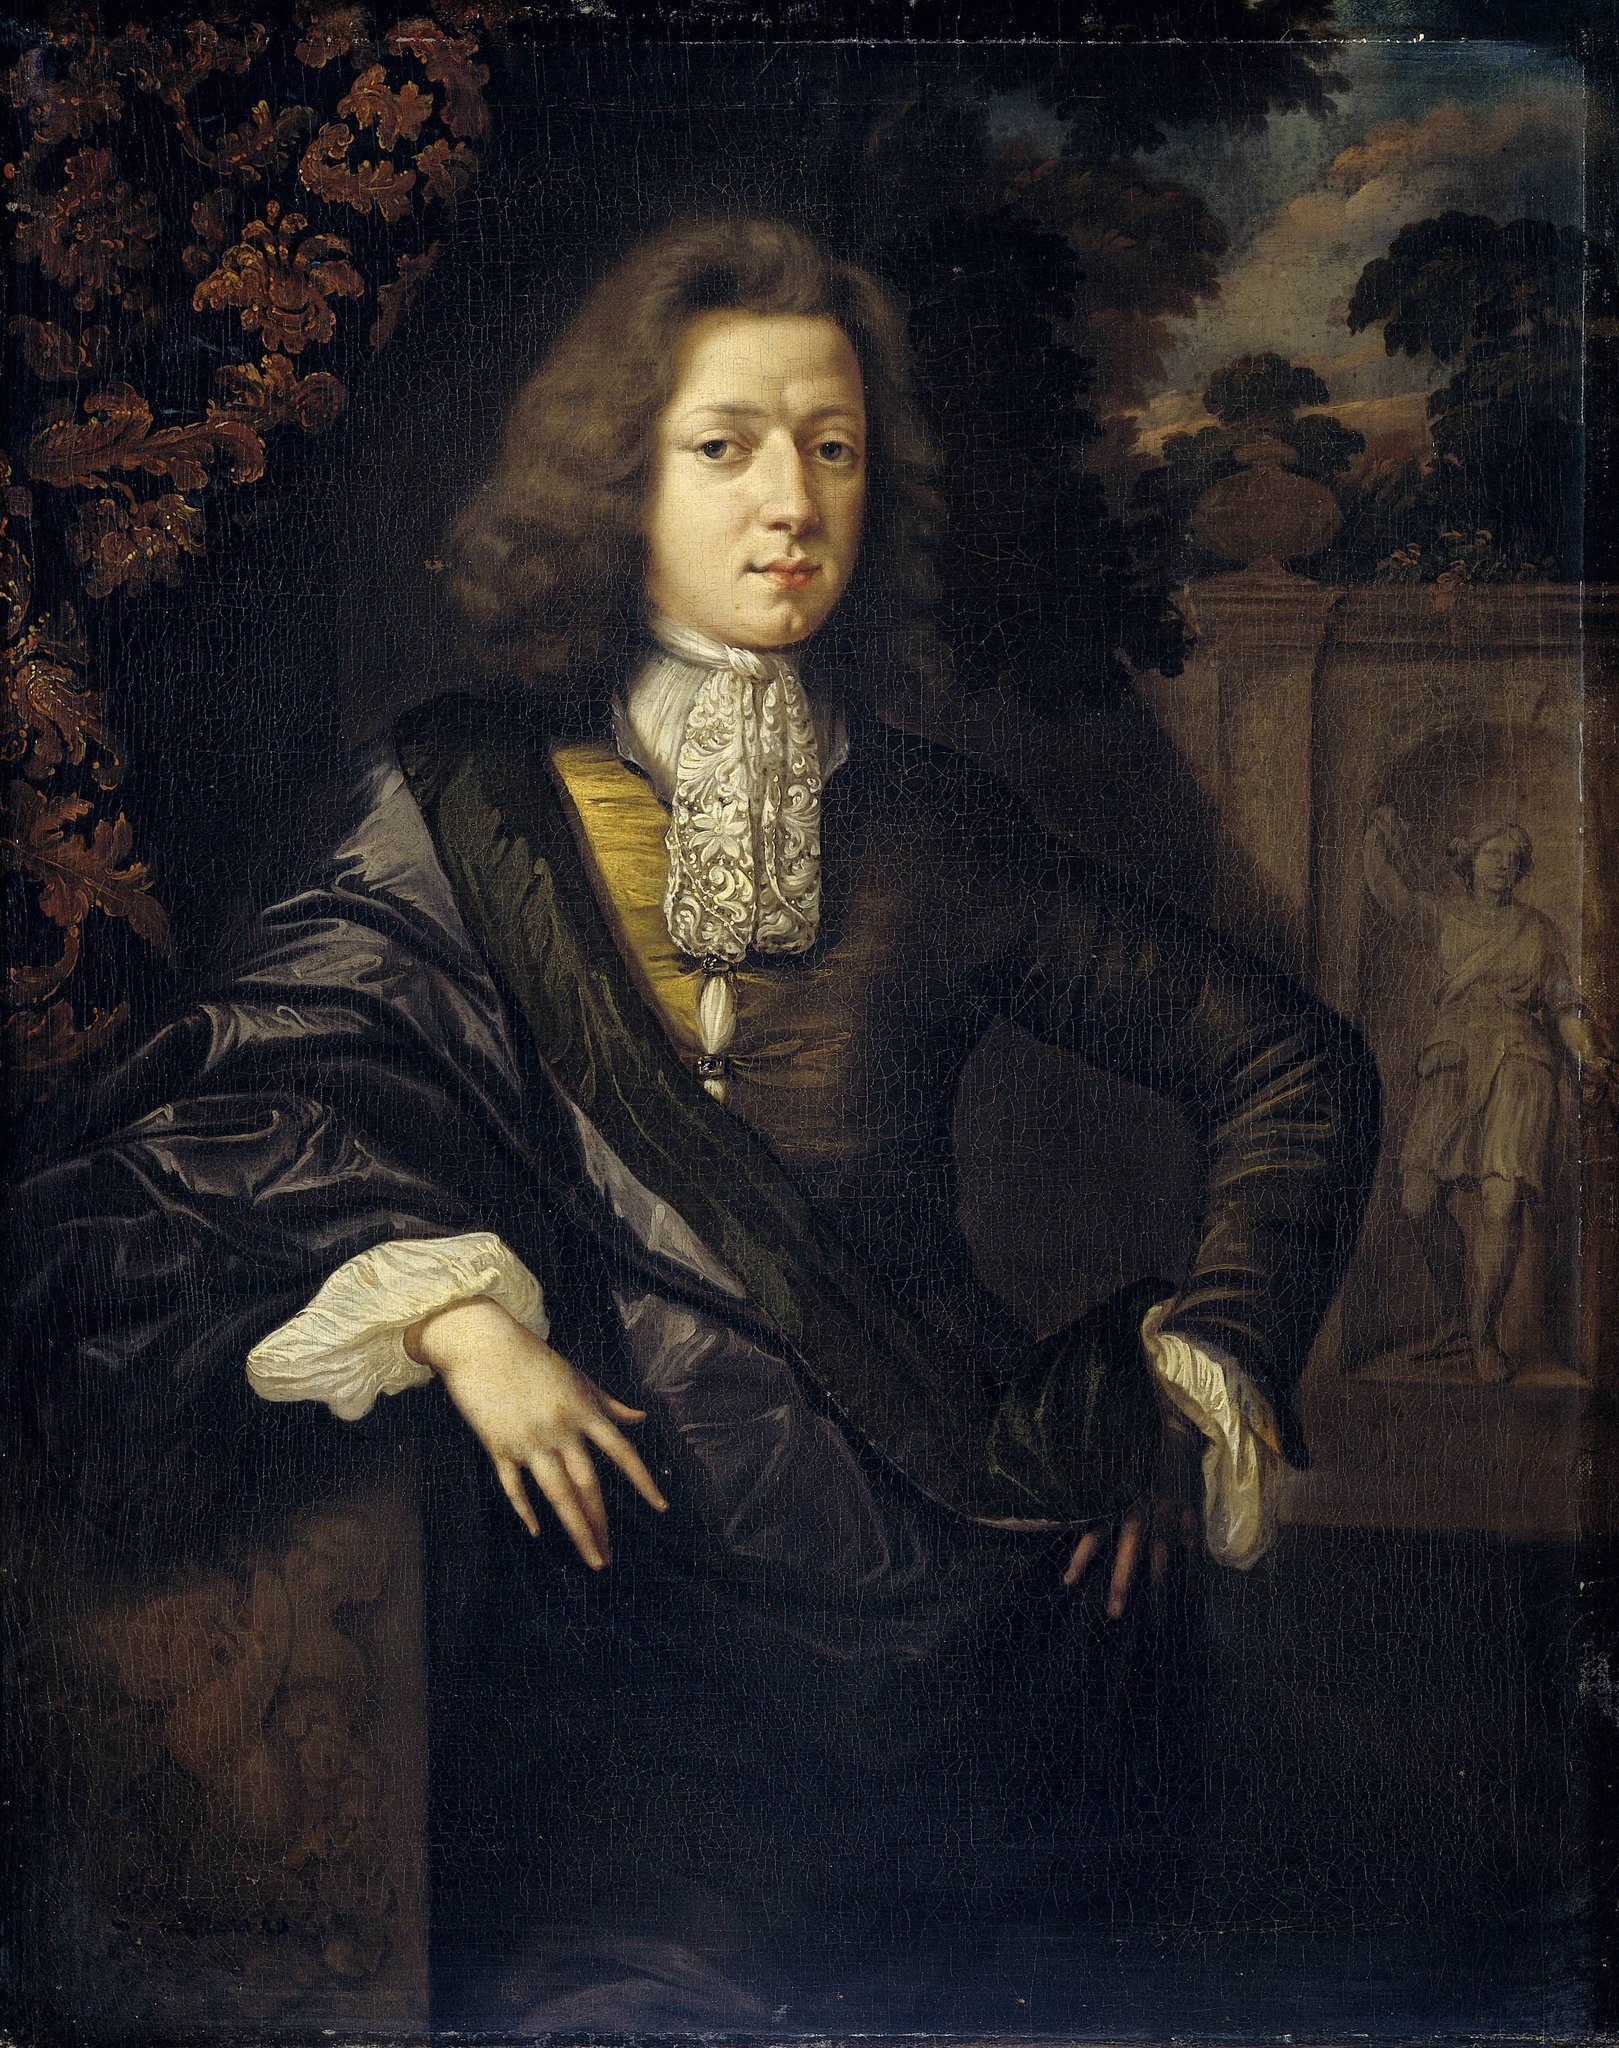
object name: painting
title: Johan van Bochoven (1624-93), Public Prosecutor and Councillor at the Court of Flanders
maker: daniël haringh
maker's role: painter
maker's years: 1636-1713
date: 1670-1690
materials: canvas, oil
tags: middelburg, historical persons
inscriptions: signature: ‘D. Haringh F.’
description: Portret van Johan van Bochoven, advocaat-fiscaal, raadsheer in het Hof van Vlaanderen. Kniestuk, leunend met de rechterarm op een voetstuk, de linkerhand in de zij. Rechts op de achtergrond een gezicht naar de tuin met een standbeeld in een nis. Pendant van SK-A-1655.